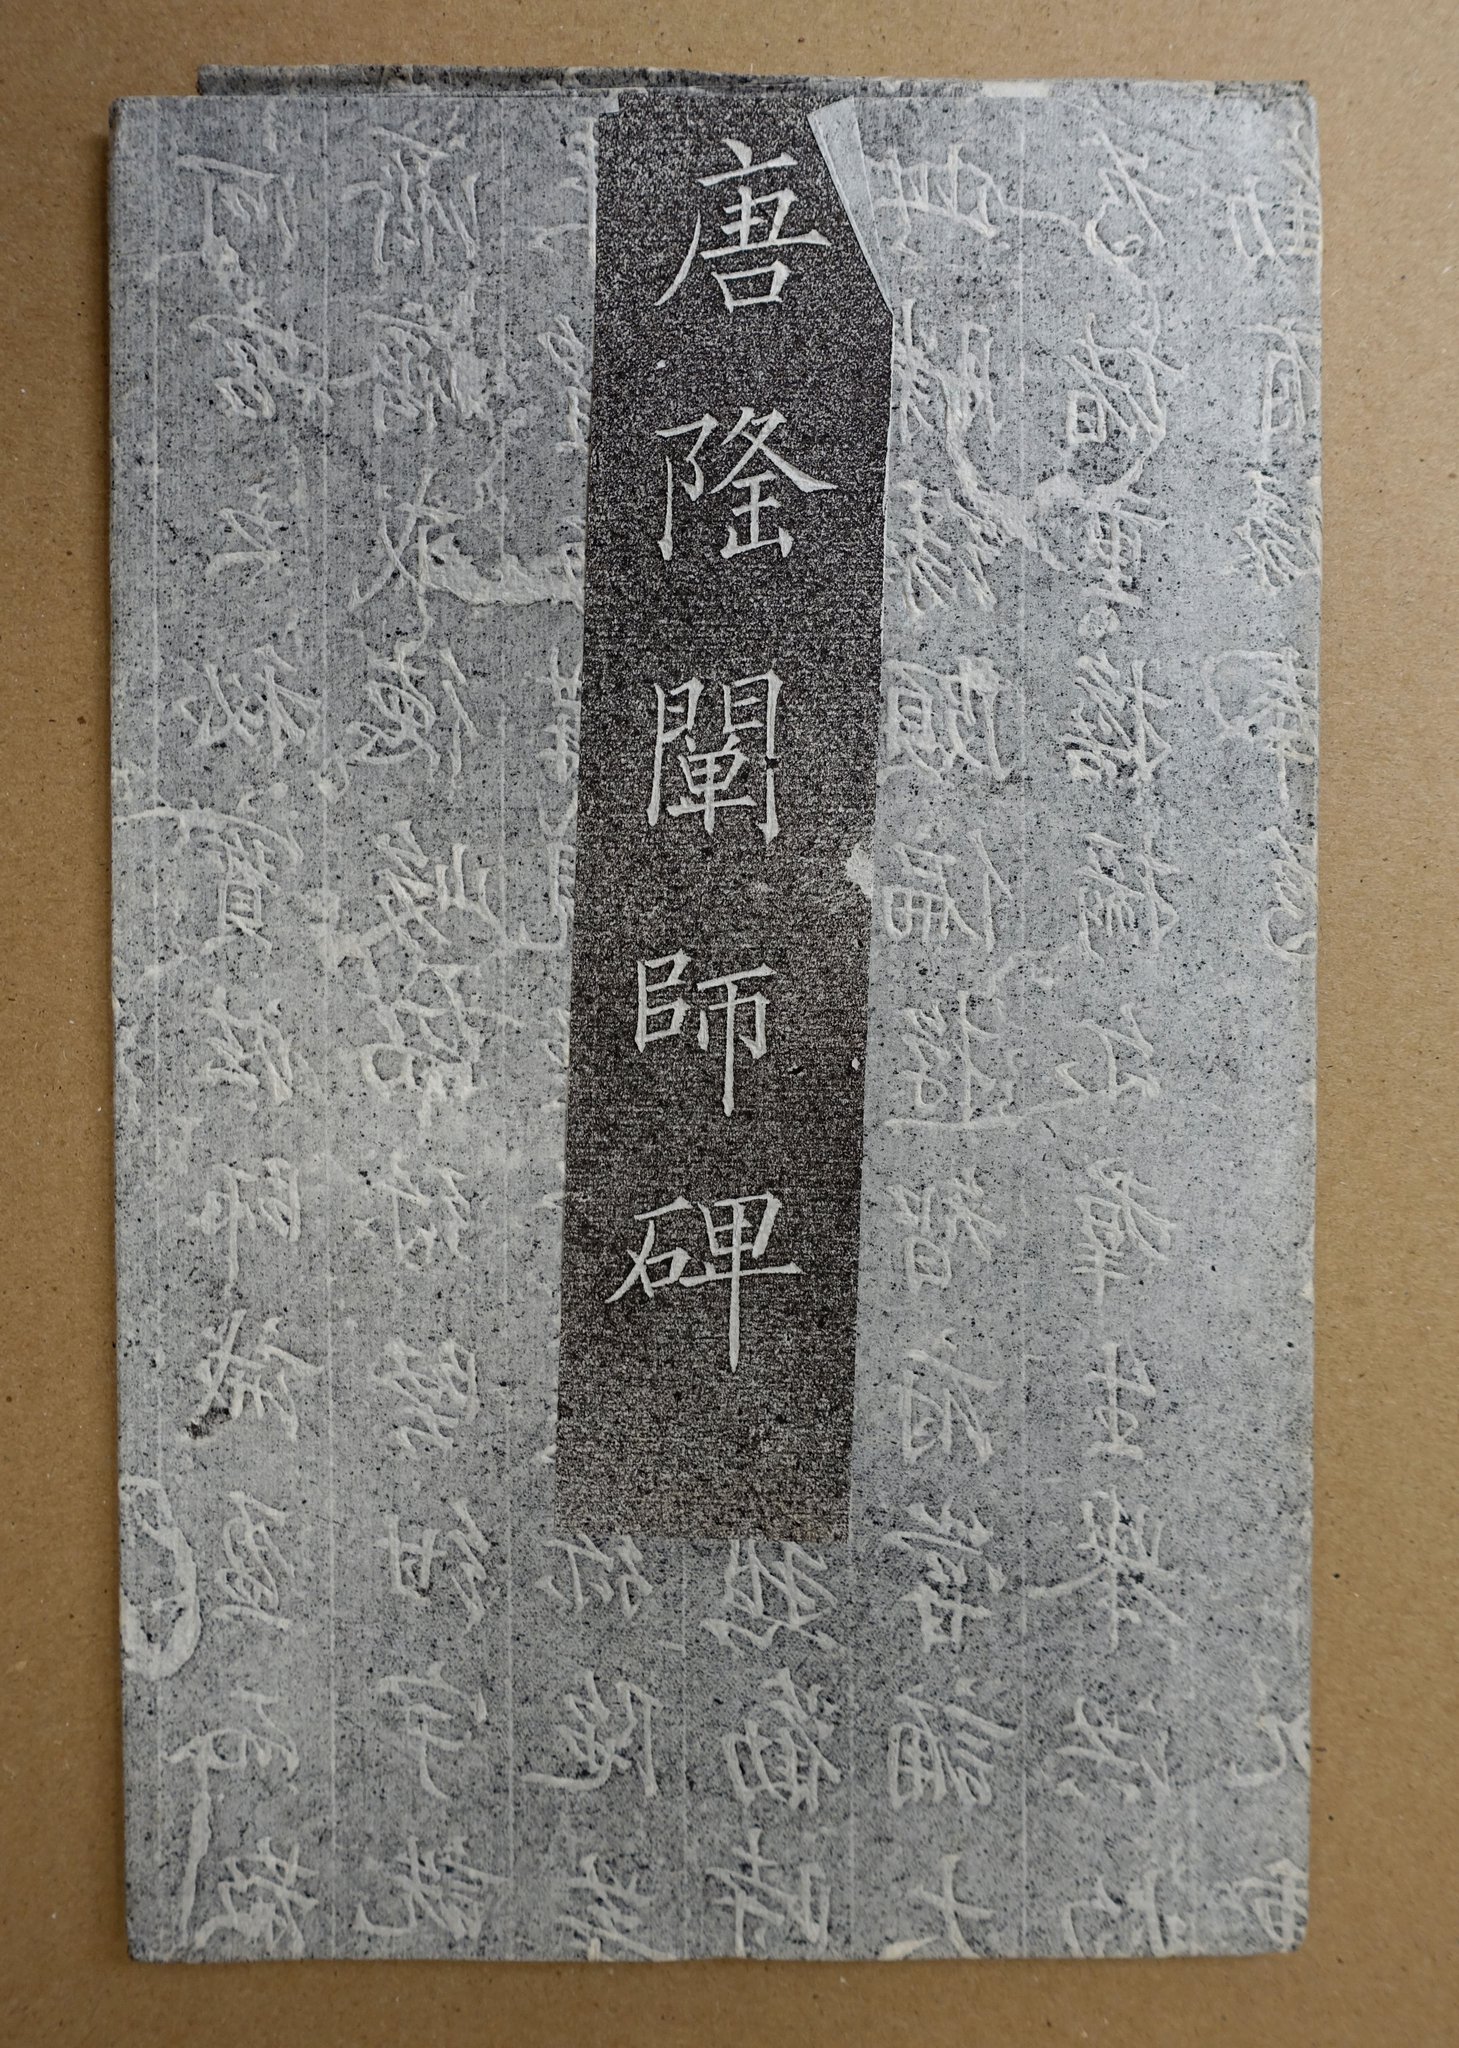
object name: rubbing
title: Epitaph for the Abbot Longchan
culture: chinese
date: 1901-2000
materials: ink, paper